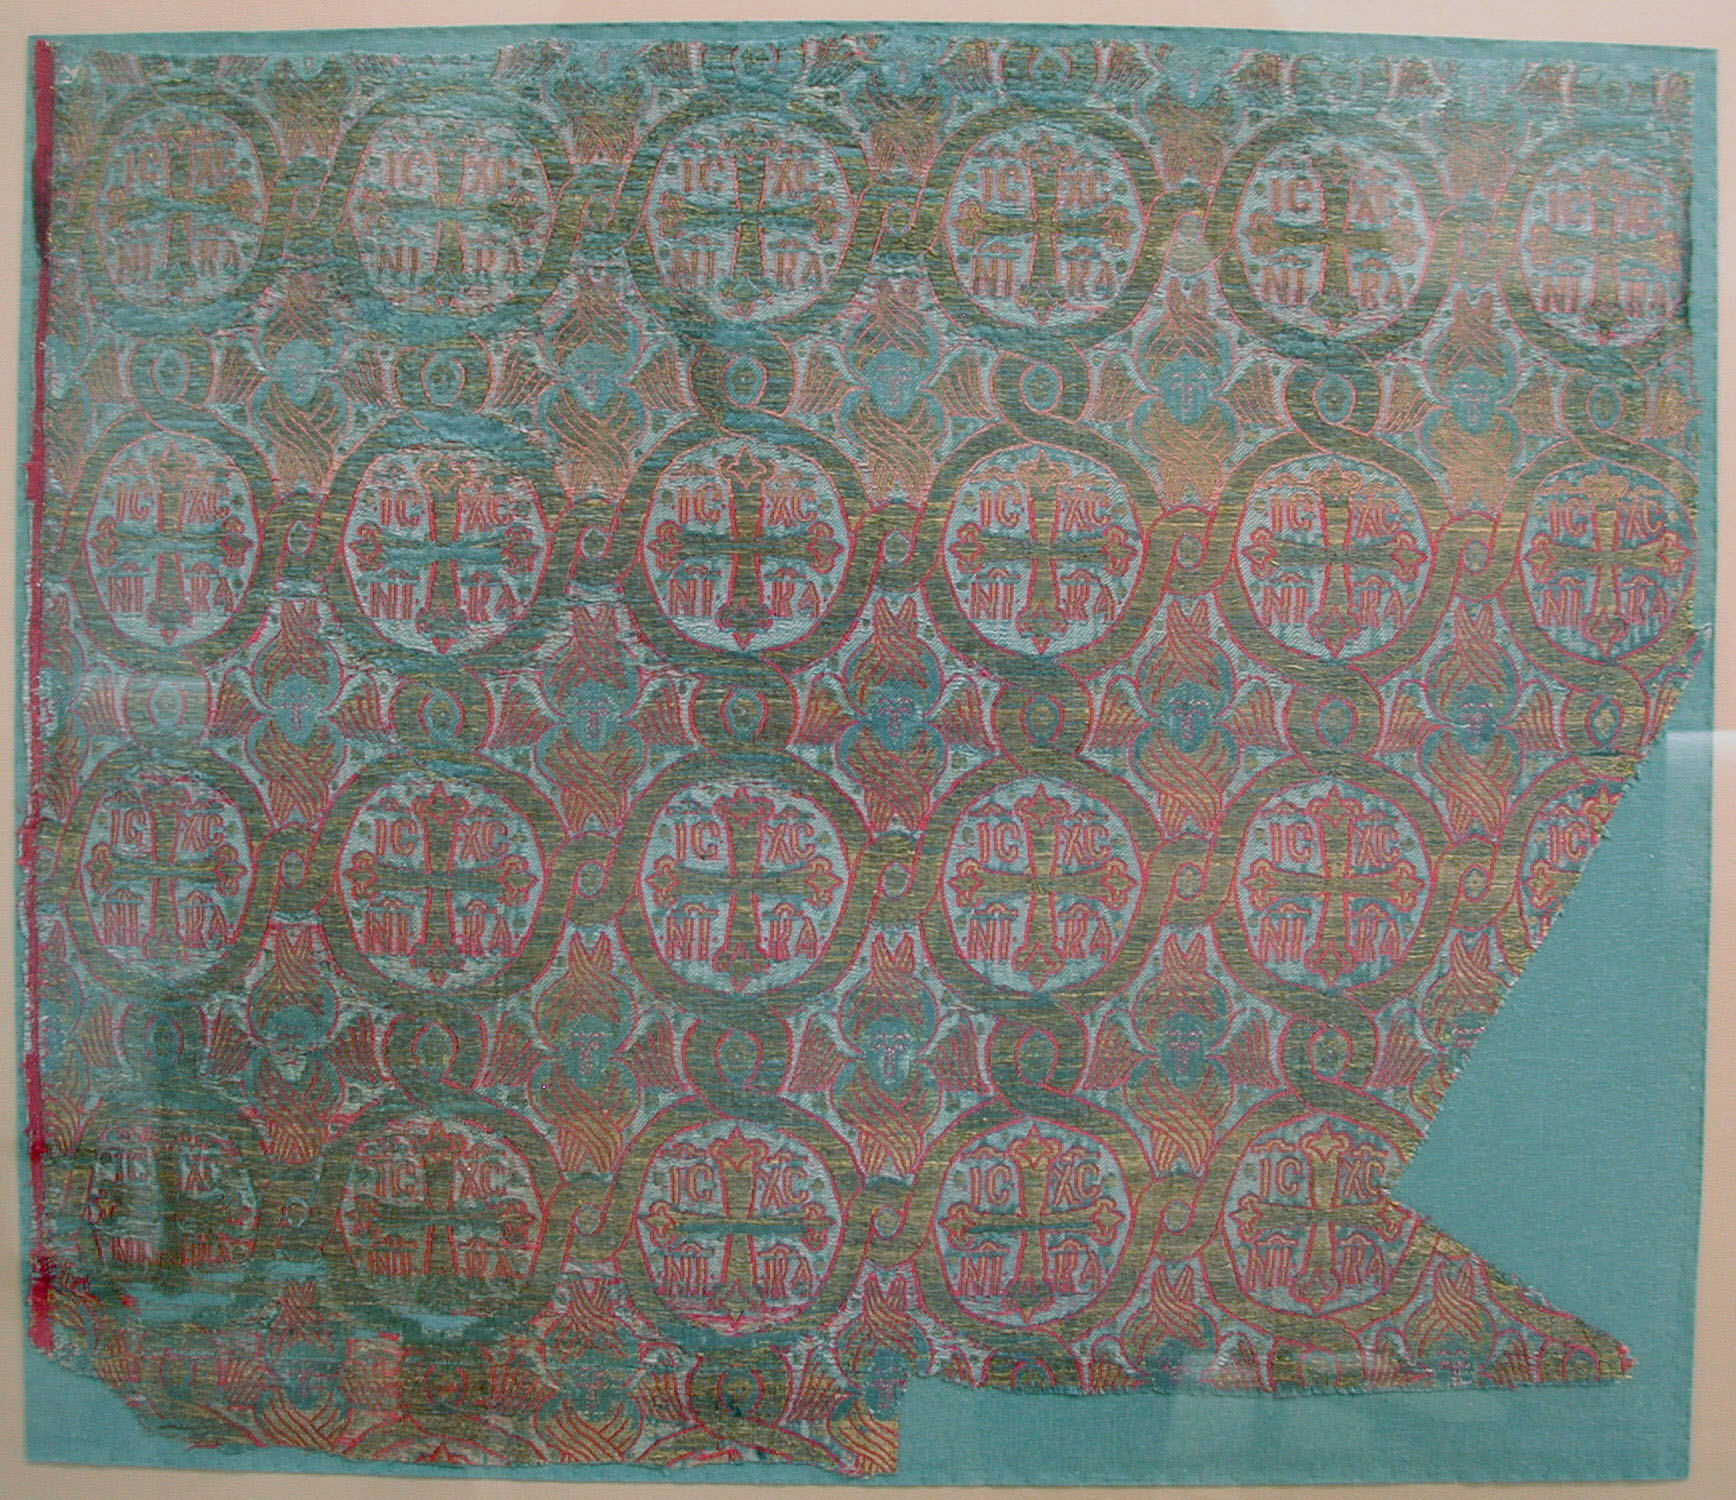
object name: textile fragment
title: Silk Textile with Seraphim and Crosses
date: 1501-1700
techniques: lampas, weave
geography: turkey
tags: cross